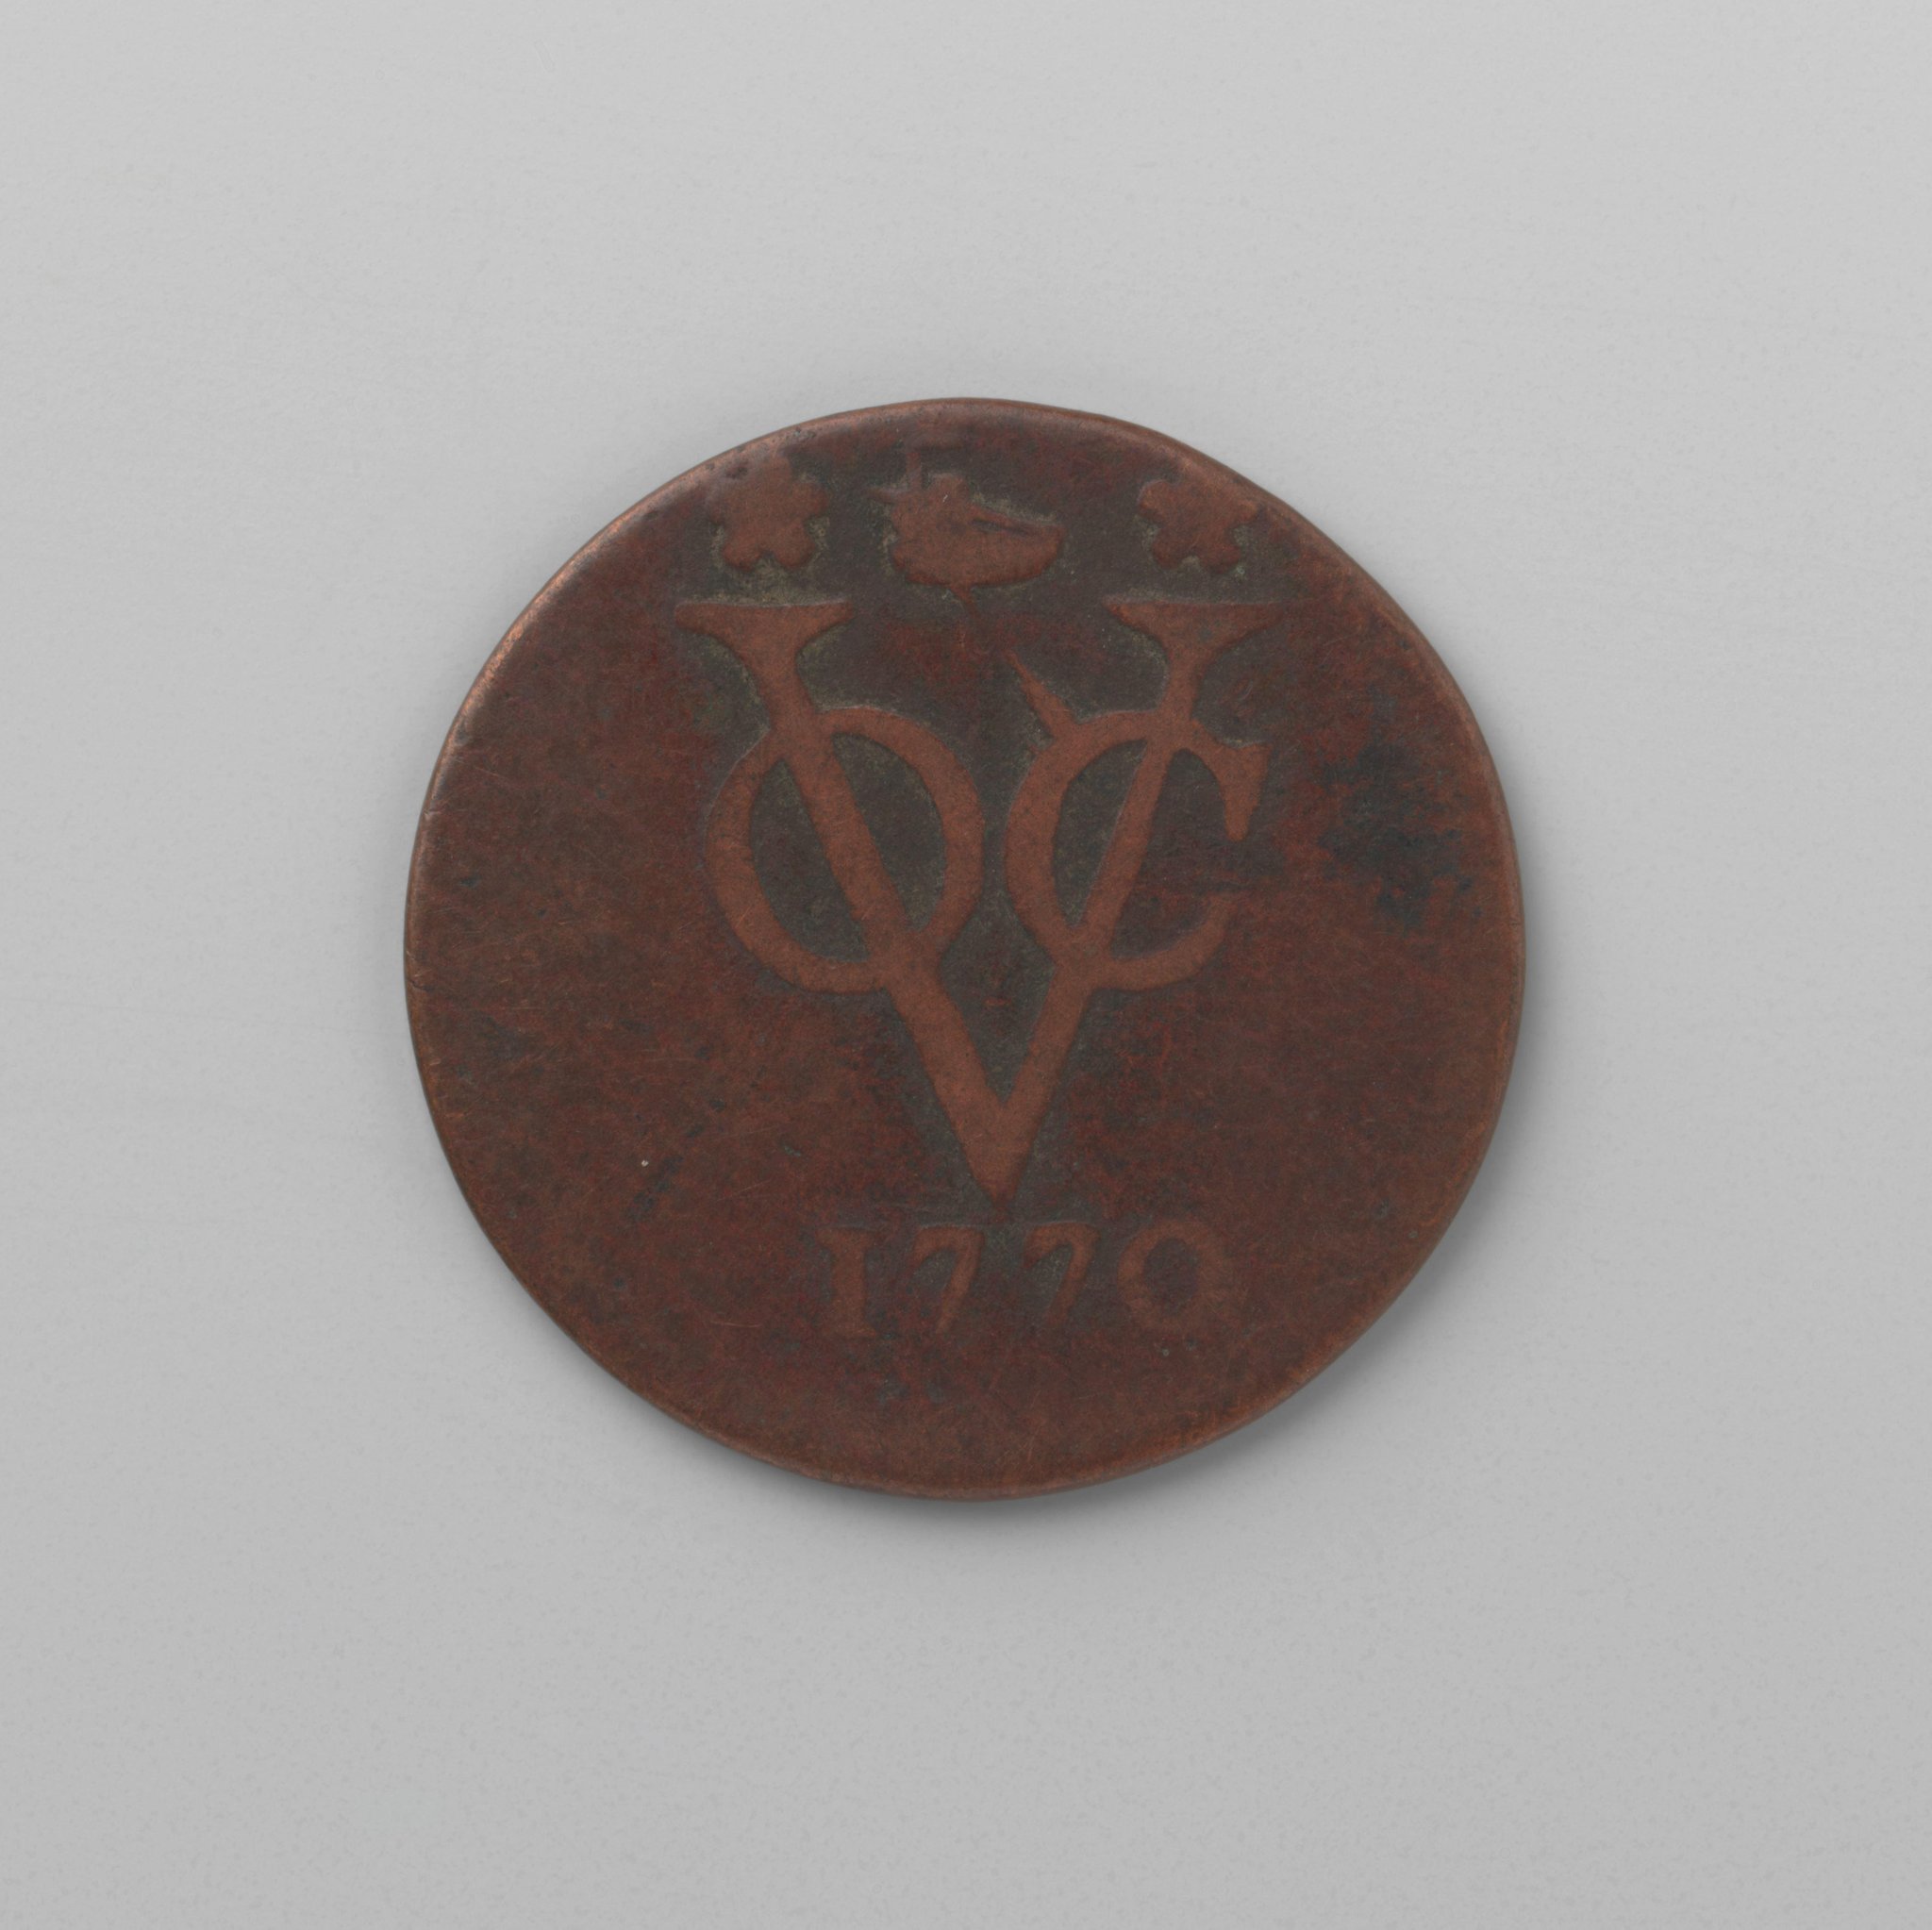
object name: coin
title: Duit van de VOC uit Westfriesland,1770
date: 1770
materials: copper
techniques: striking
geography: enkhuizen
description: Koperen munt. Voorzijde: gekroond wapenschild van Westfriesland. Keerzijde: monogram van de VOC, waarboven muntmeesterteken en waaronder jaartal. Gladde rand.